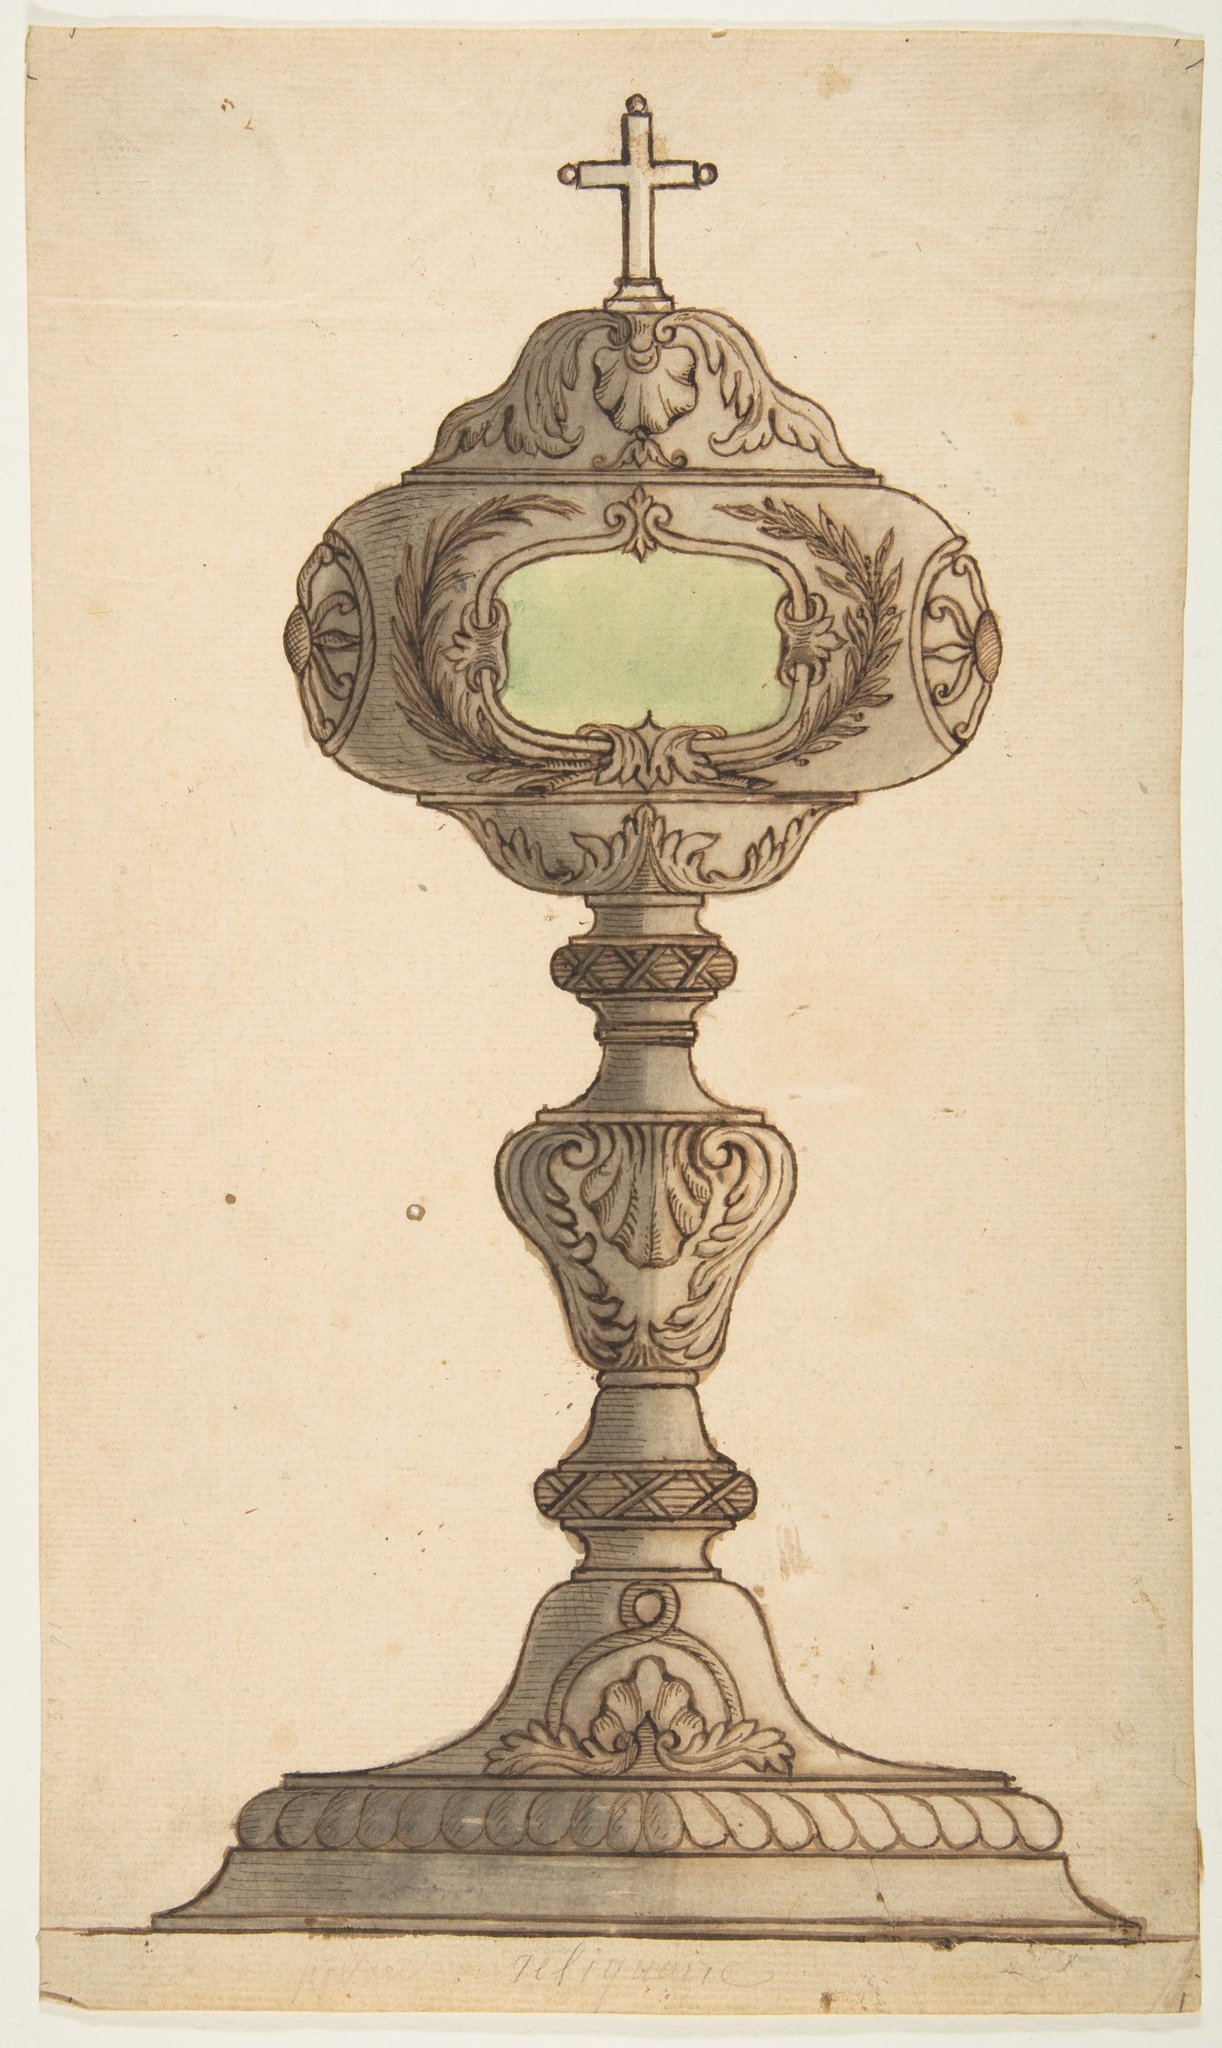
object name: drawing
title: Reliquary Design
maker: anonymous, french, 19th century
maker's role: artist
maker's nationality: french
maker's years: 1800-1900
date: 1801-1900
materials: ink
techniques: pen, wash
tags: cross,reliquaries